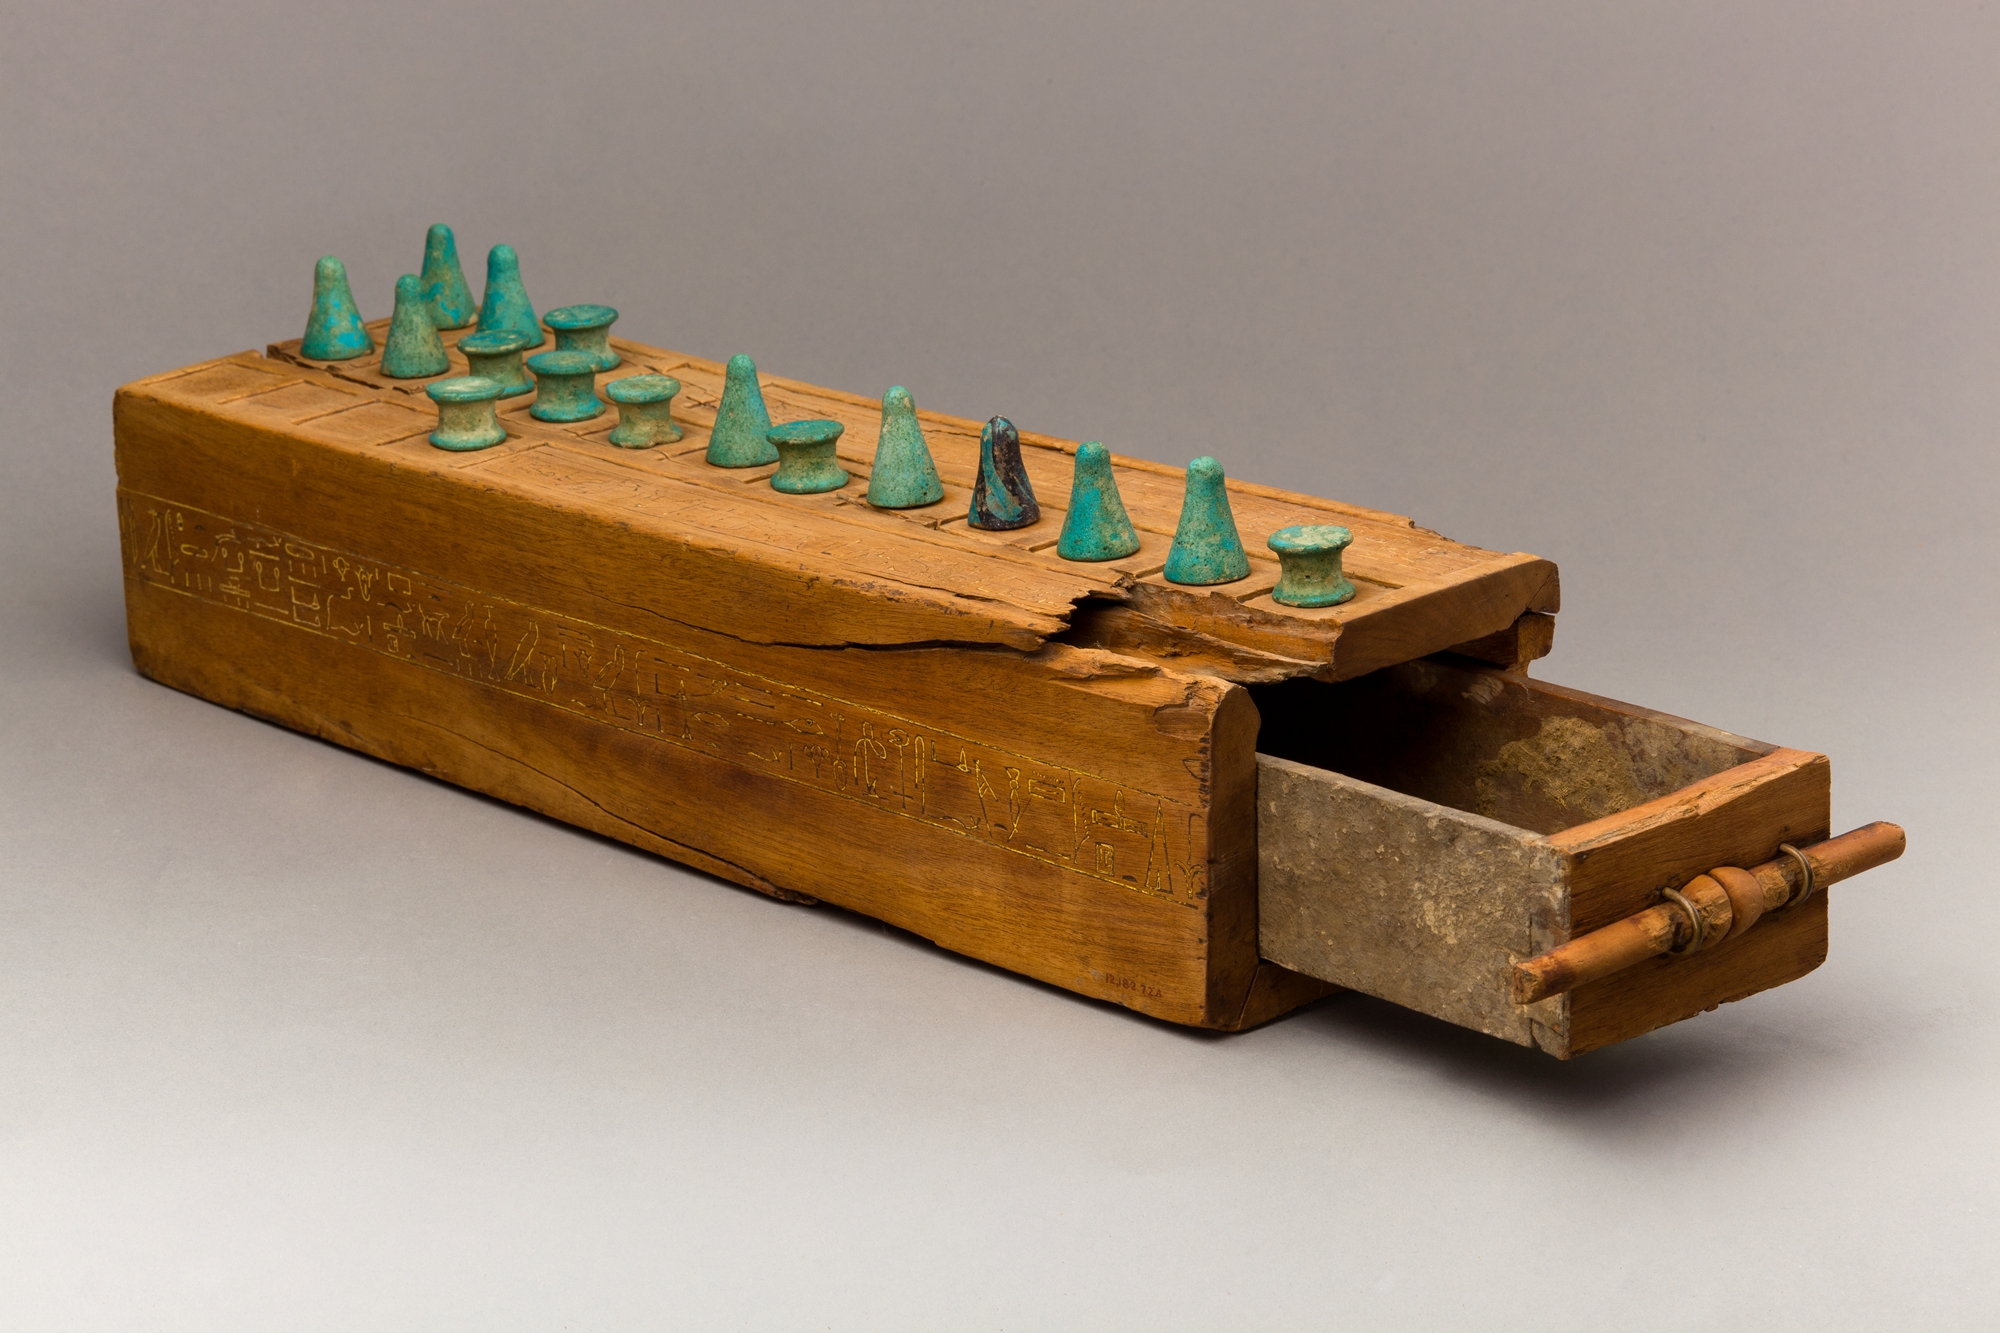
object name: senet board, taia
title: Game Box Inscribed for Taia and His Family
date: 1550-1295 BCE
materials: wood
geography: egypt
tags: hieroglyphs,games